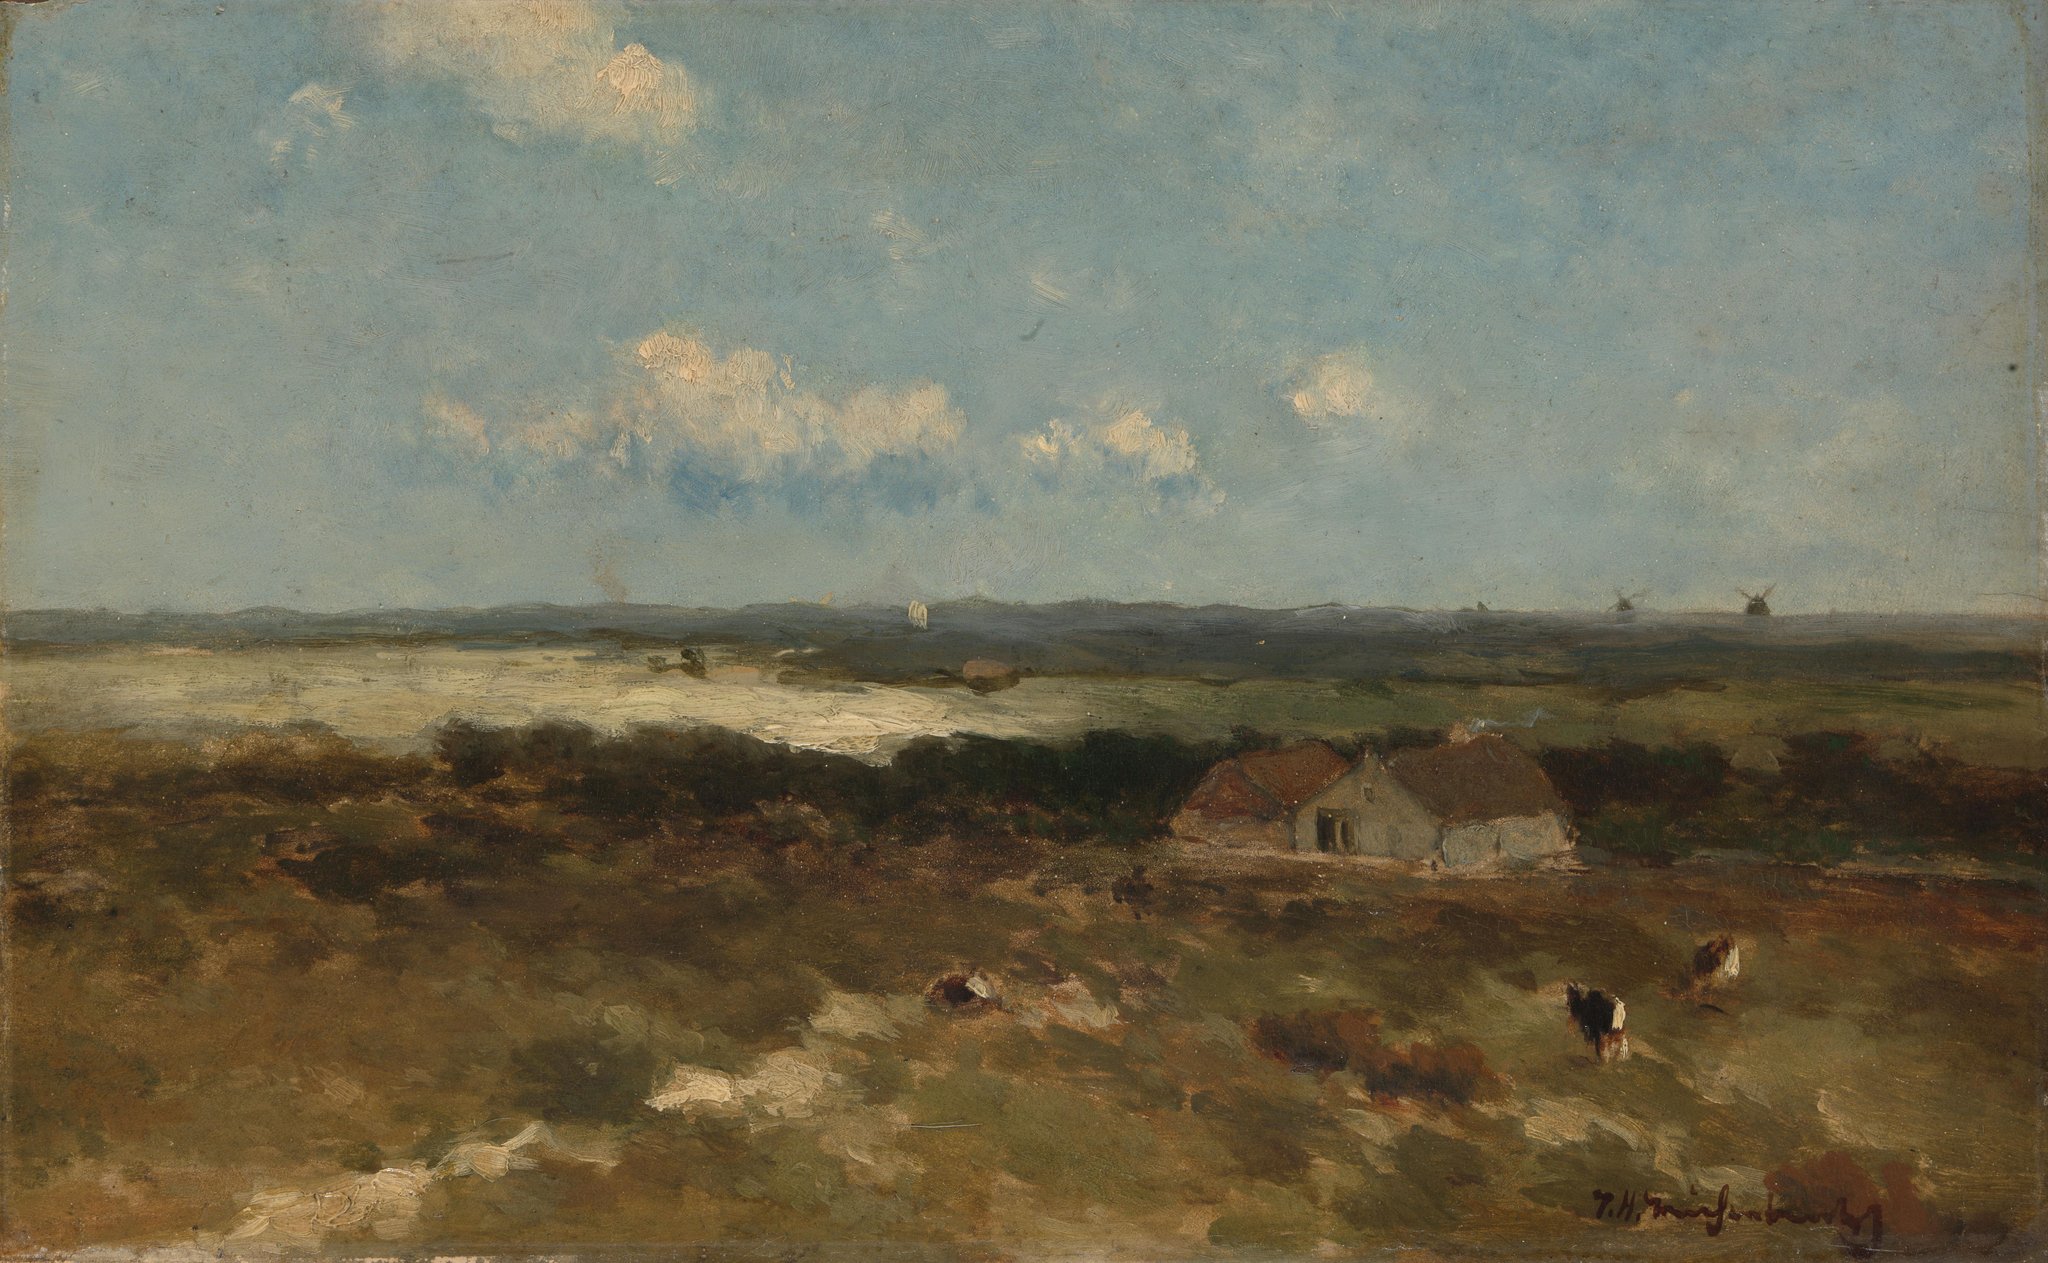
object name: painting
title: Dune landscape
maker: johan hendrik weissenbruch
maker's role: draughtsman, painter, print maker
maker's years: 1824-1903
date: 1870-1896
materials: oil, panel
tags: dunes (sea not visible); in the dunes, farm or solitary house in landscape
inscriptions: signature: ‘J.H. Weissenbruch f’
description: Duinlandschap met op de voorgrond enige boerenhuizen en wat vee, aan de horizon enkele molens.